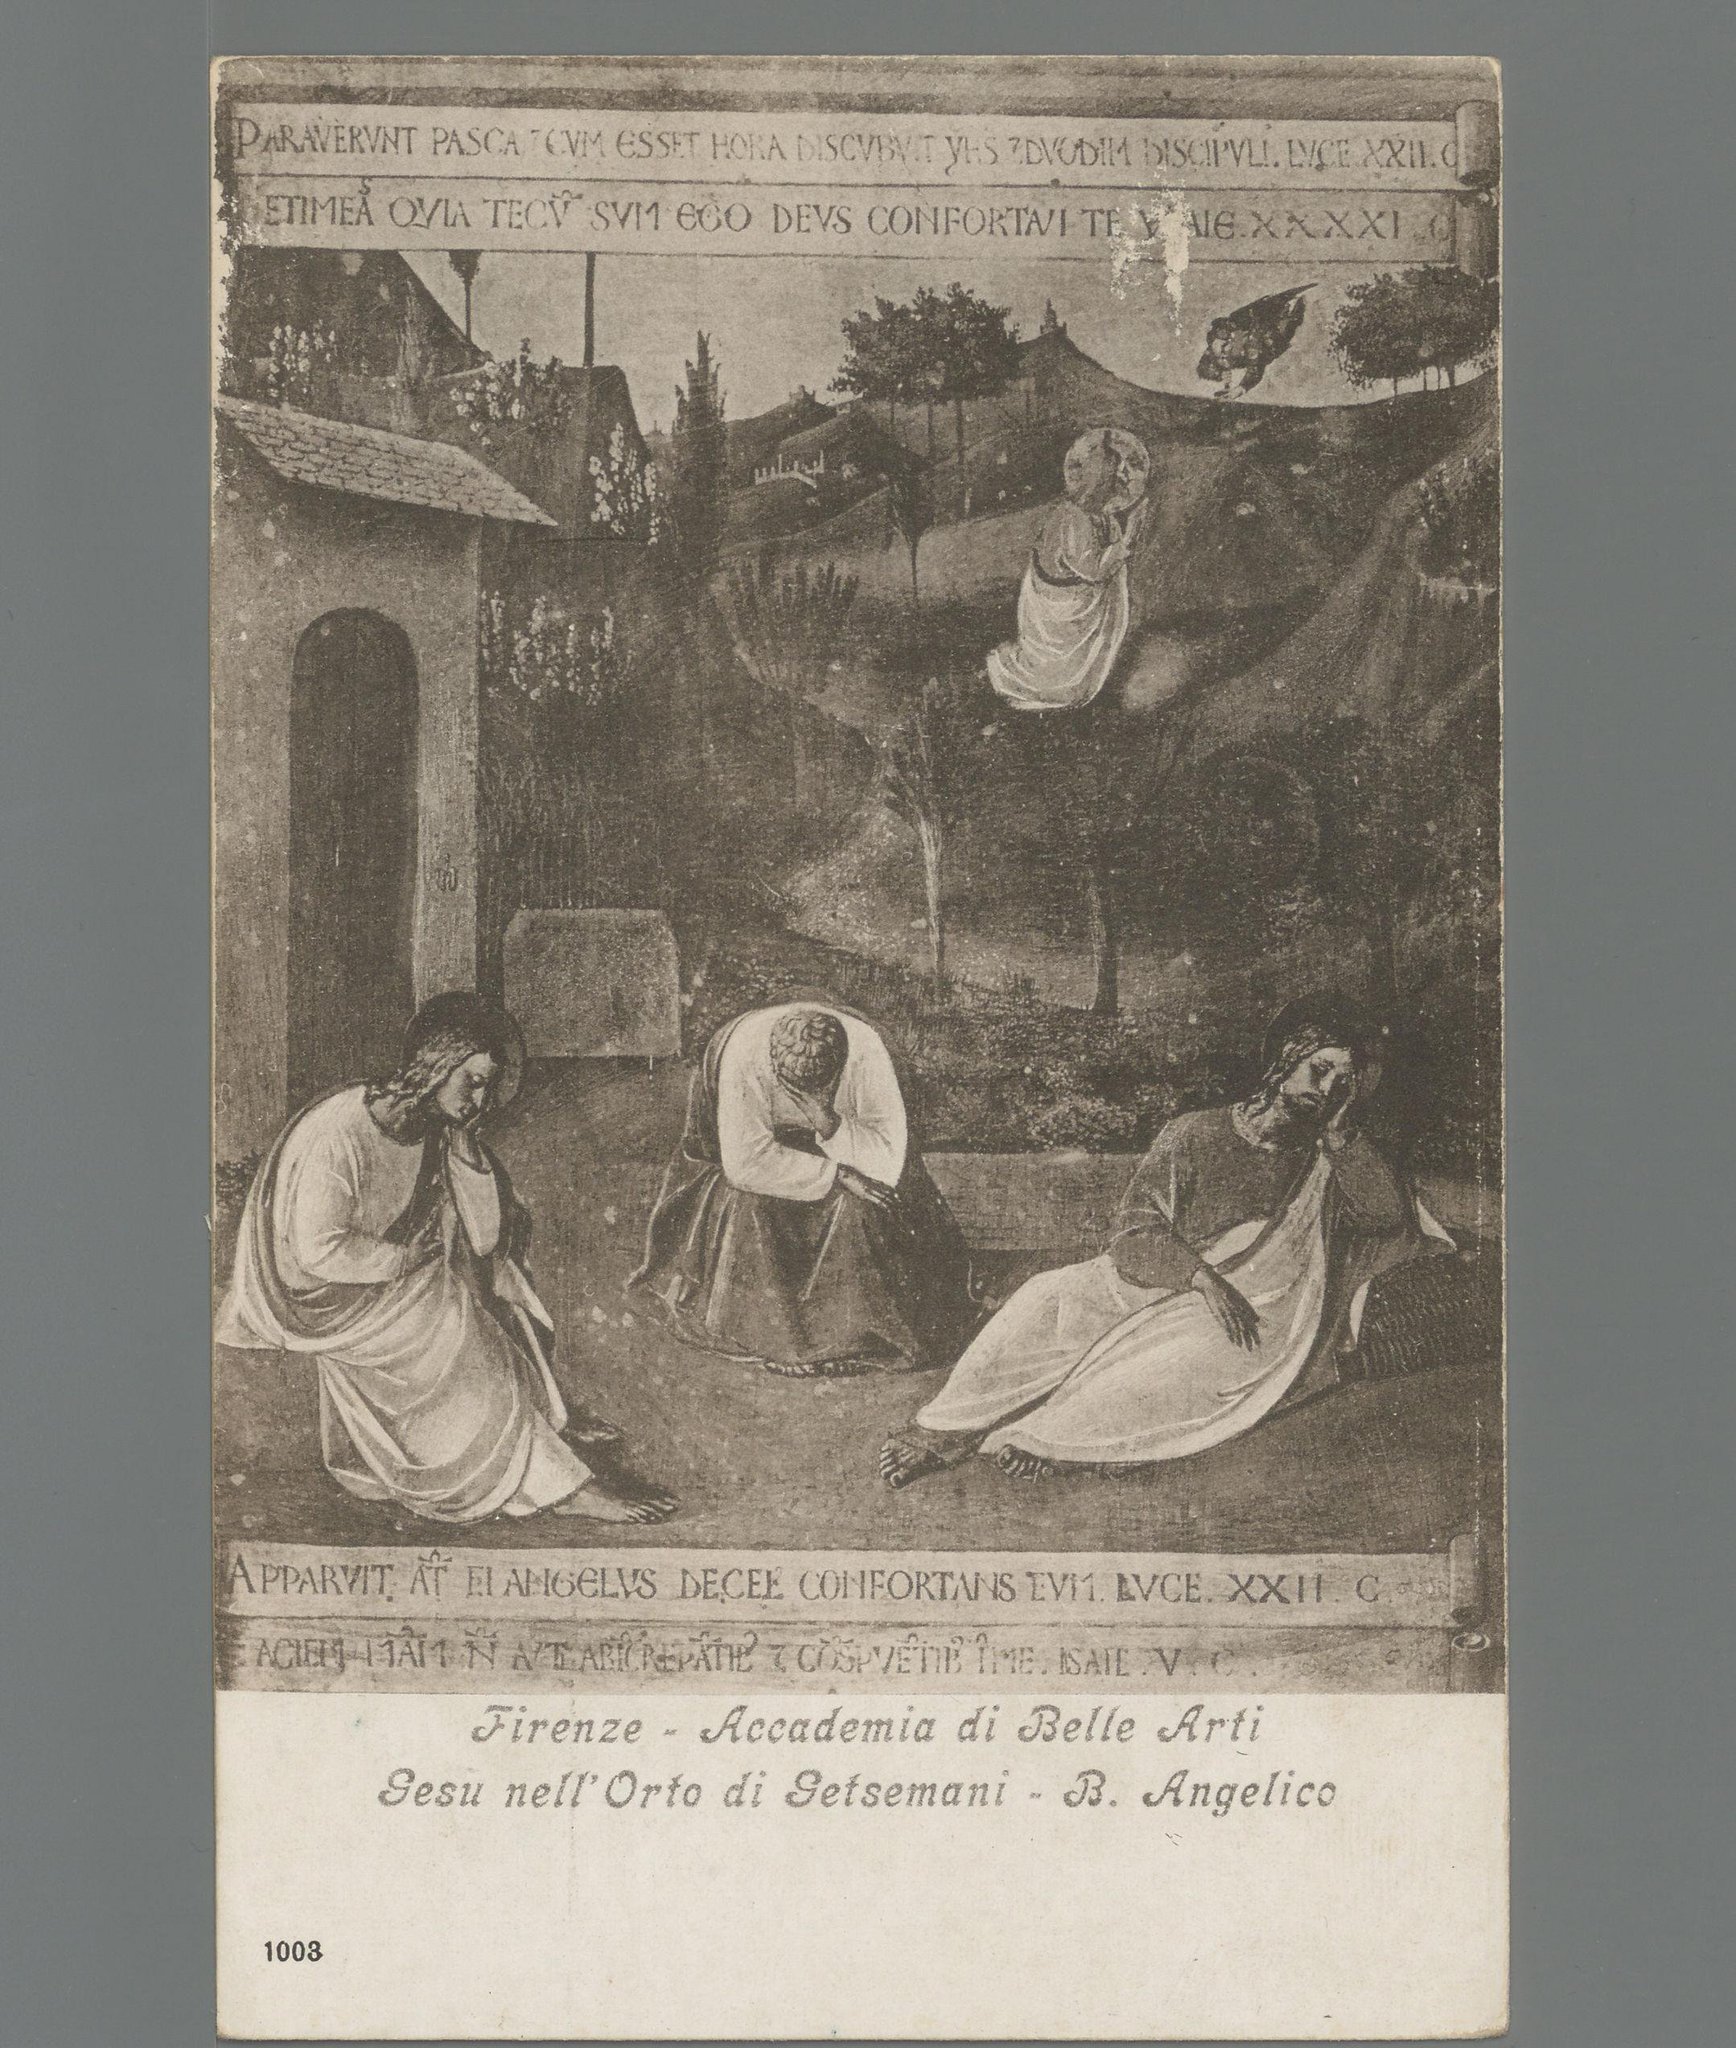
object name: reproduction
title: Firenze - Accademia di Belle Arti. Gesu nell'Orto di Getsemani - B. Angelico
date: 1906-1930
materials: cardboard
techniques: photograph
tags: permanent exhibition, museum, picture, painting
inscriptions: collector's mark: ‘AFE v S’, monogram